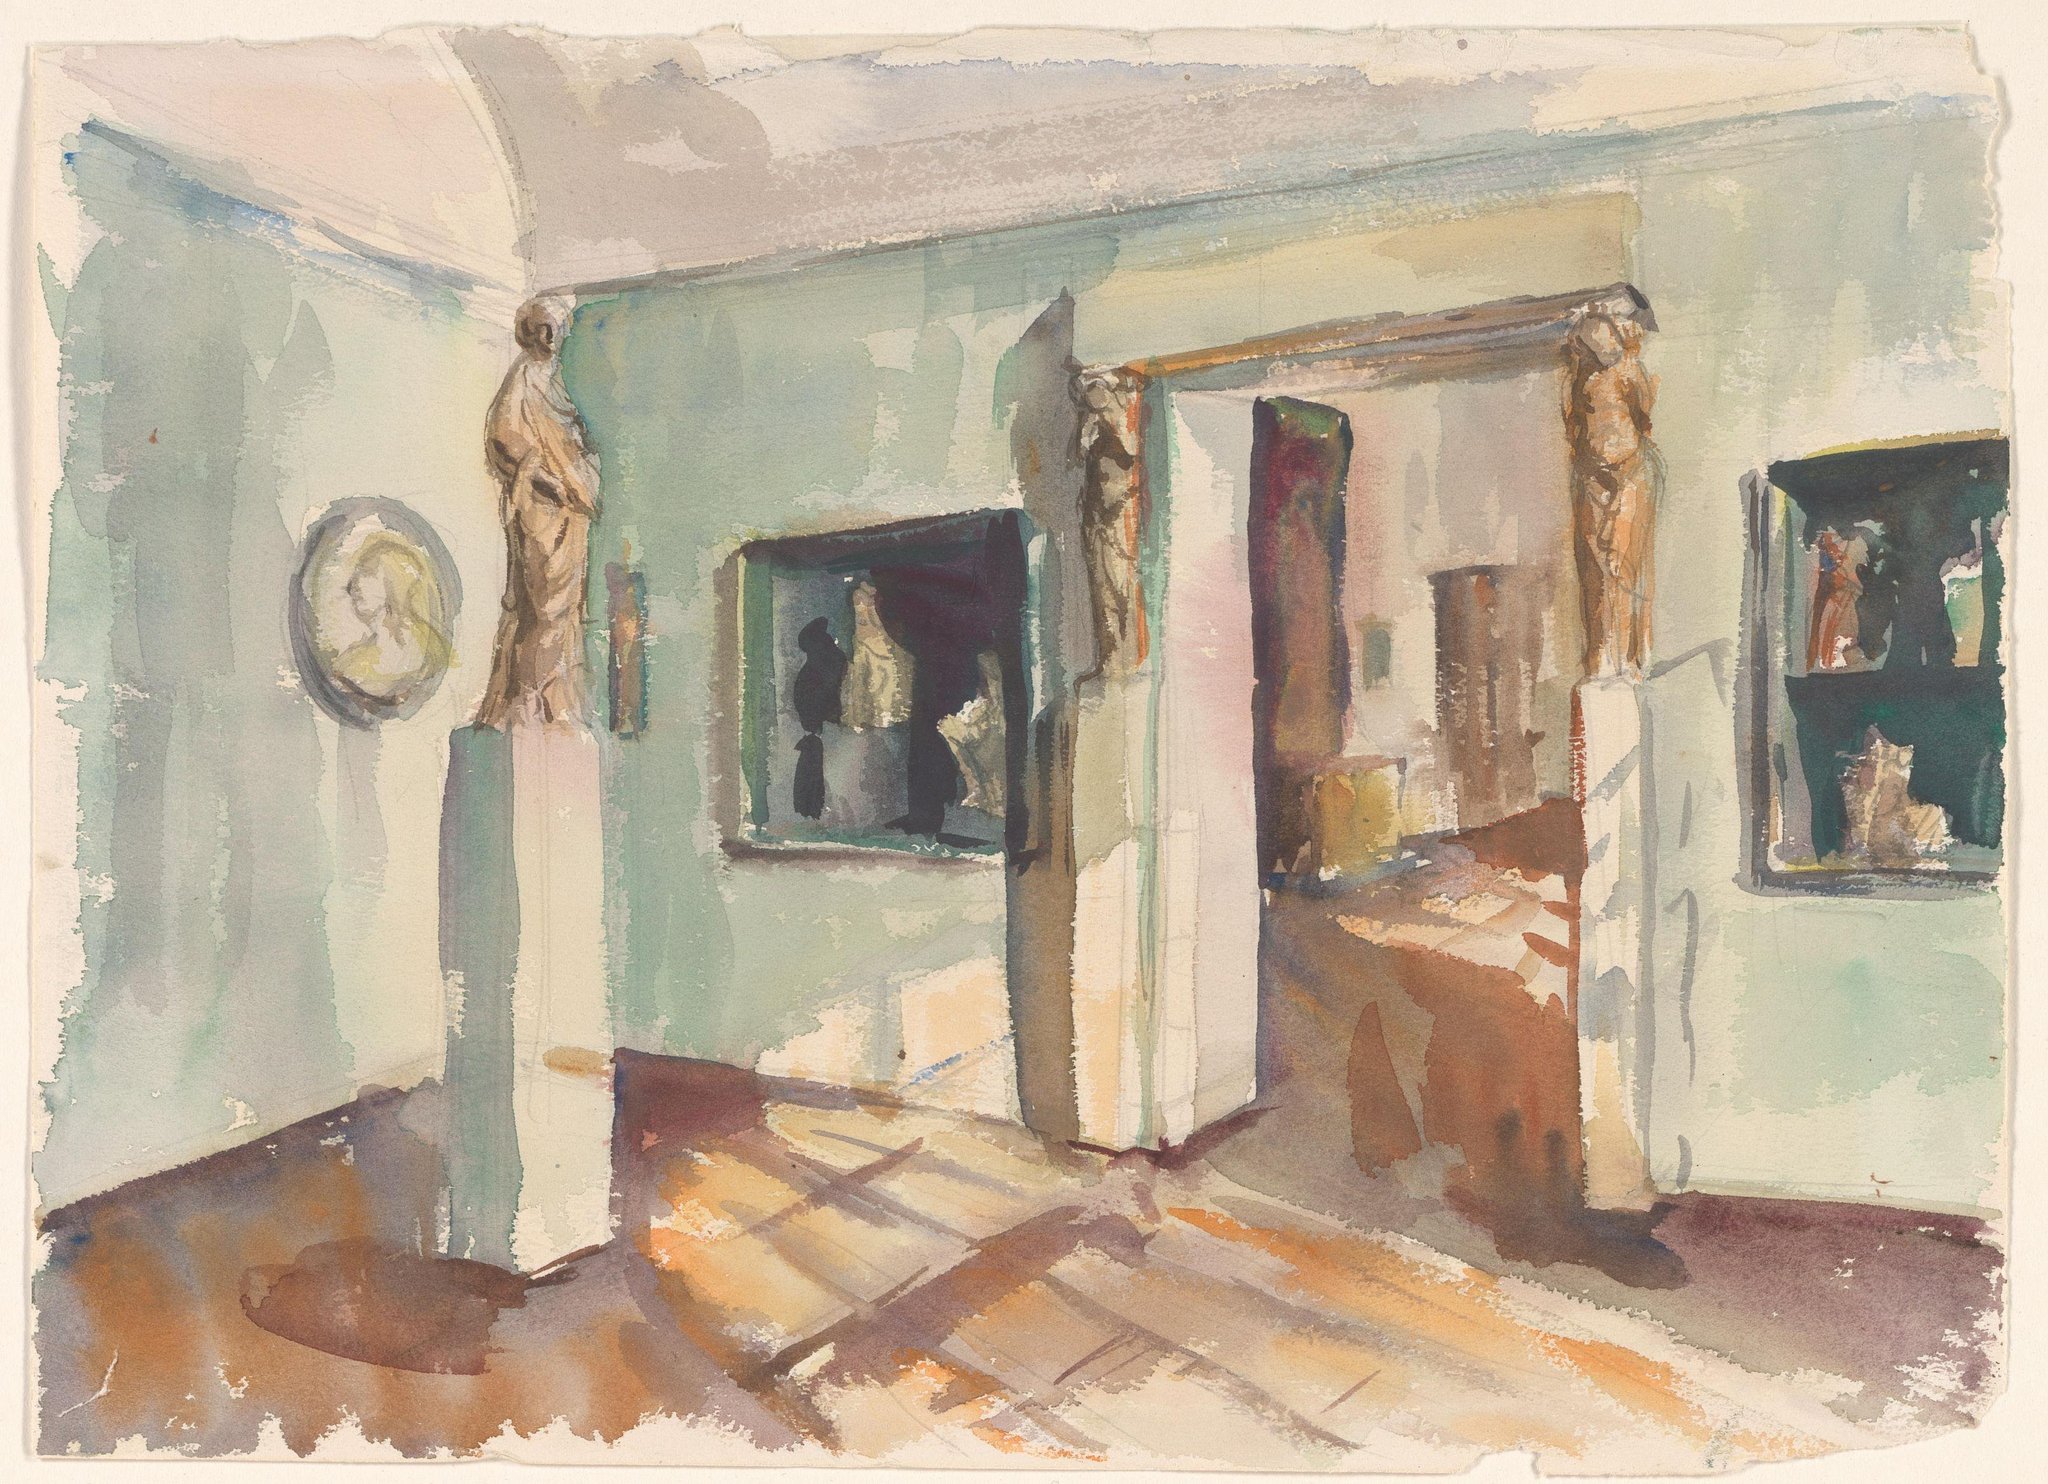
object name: watercolor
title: Gezicht in een zaal van het Rijksmuseum: beeldhouwwerken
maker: van lynden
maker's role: draughtsman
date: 1947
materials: paper, pencil, watercolor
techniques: brush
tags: permanent exhibition, museum